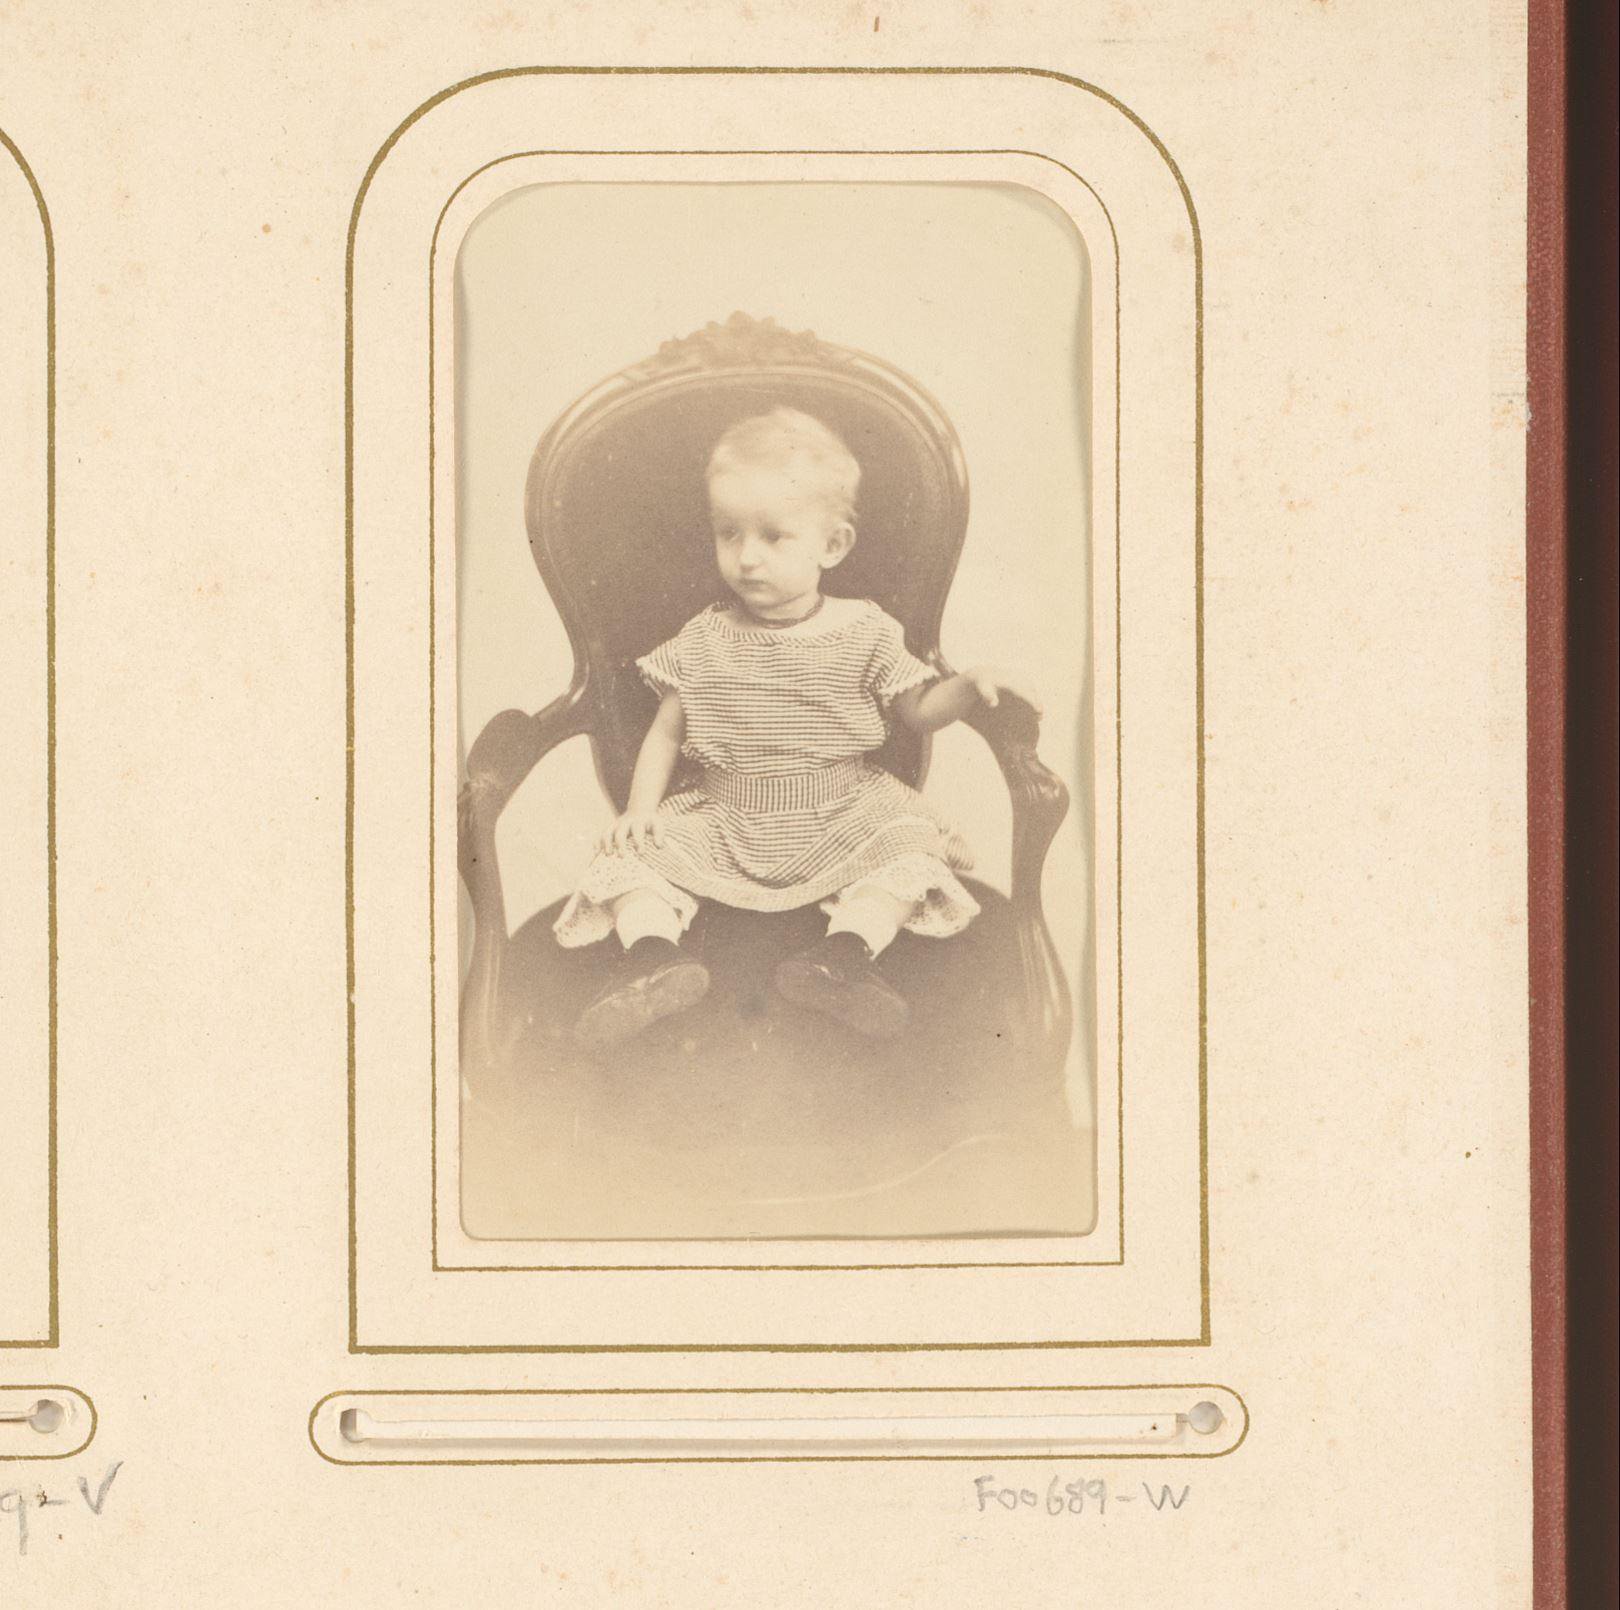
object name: album leaf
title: Portret van een kind, zittend op stoel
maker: Anonymous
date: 1860-1900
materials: cardboard, photographic support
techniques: albumen print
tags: child